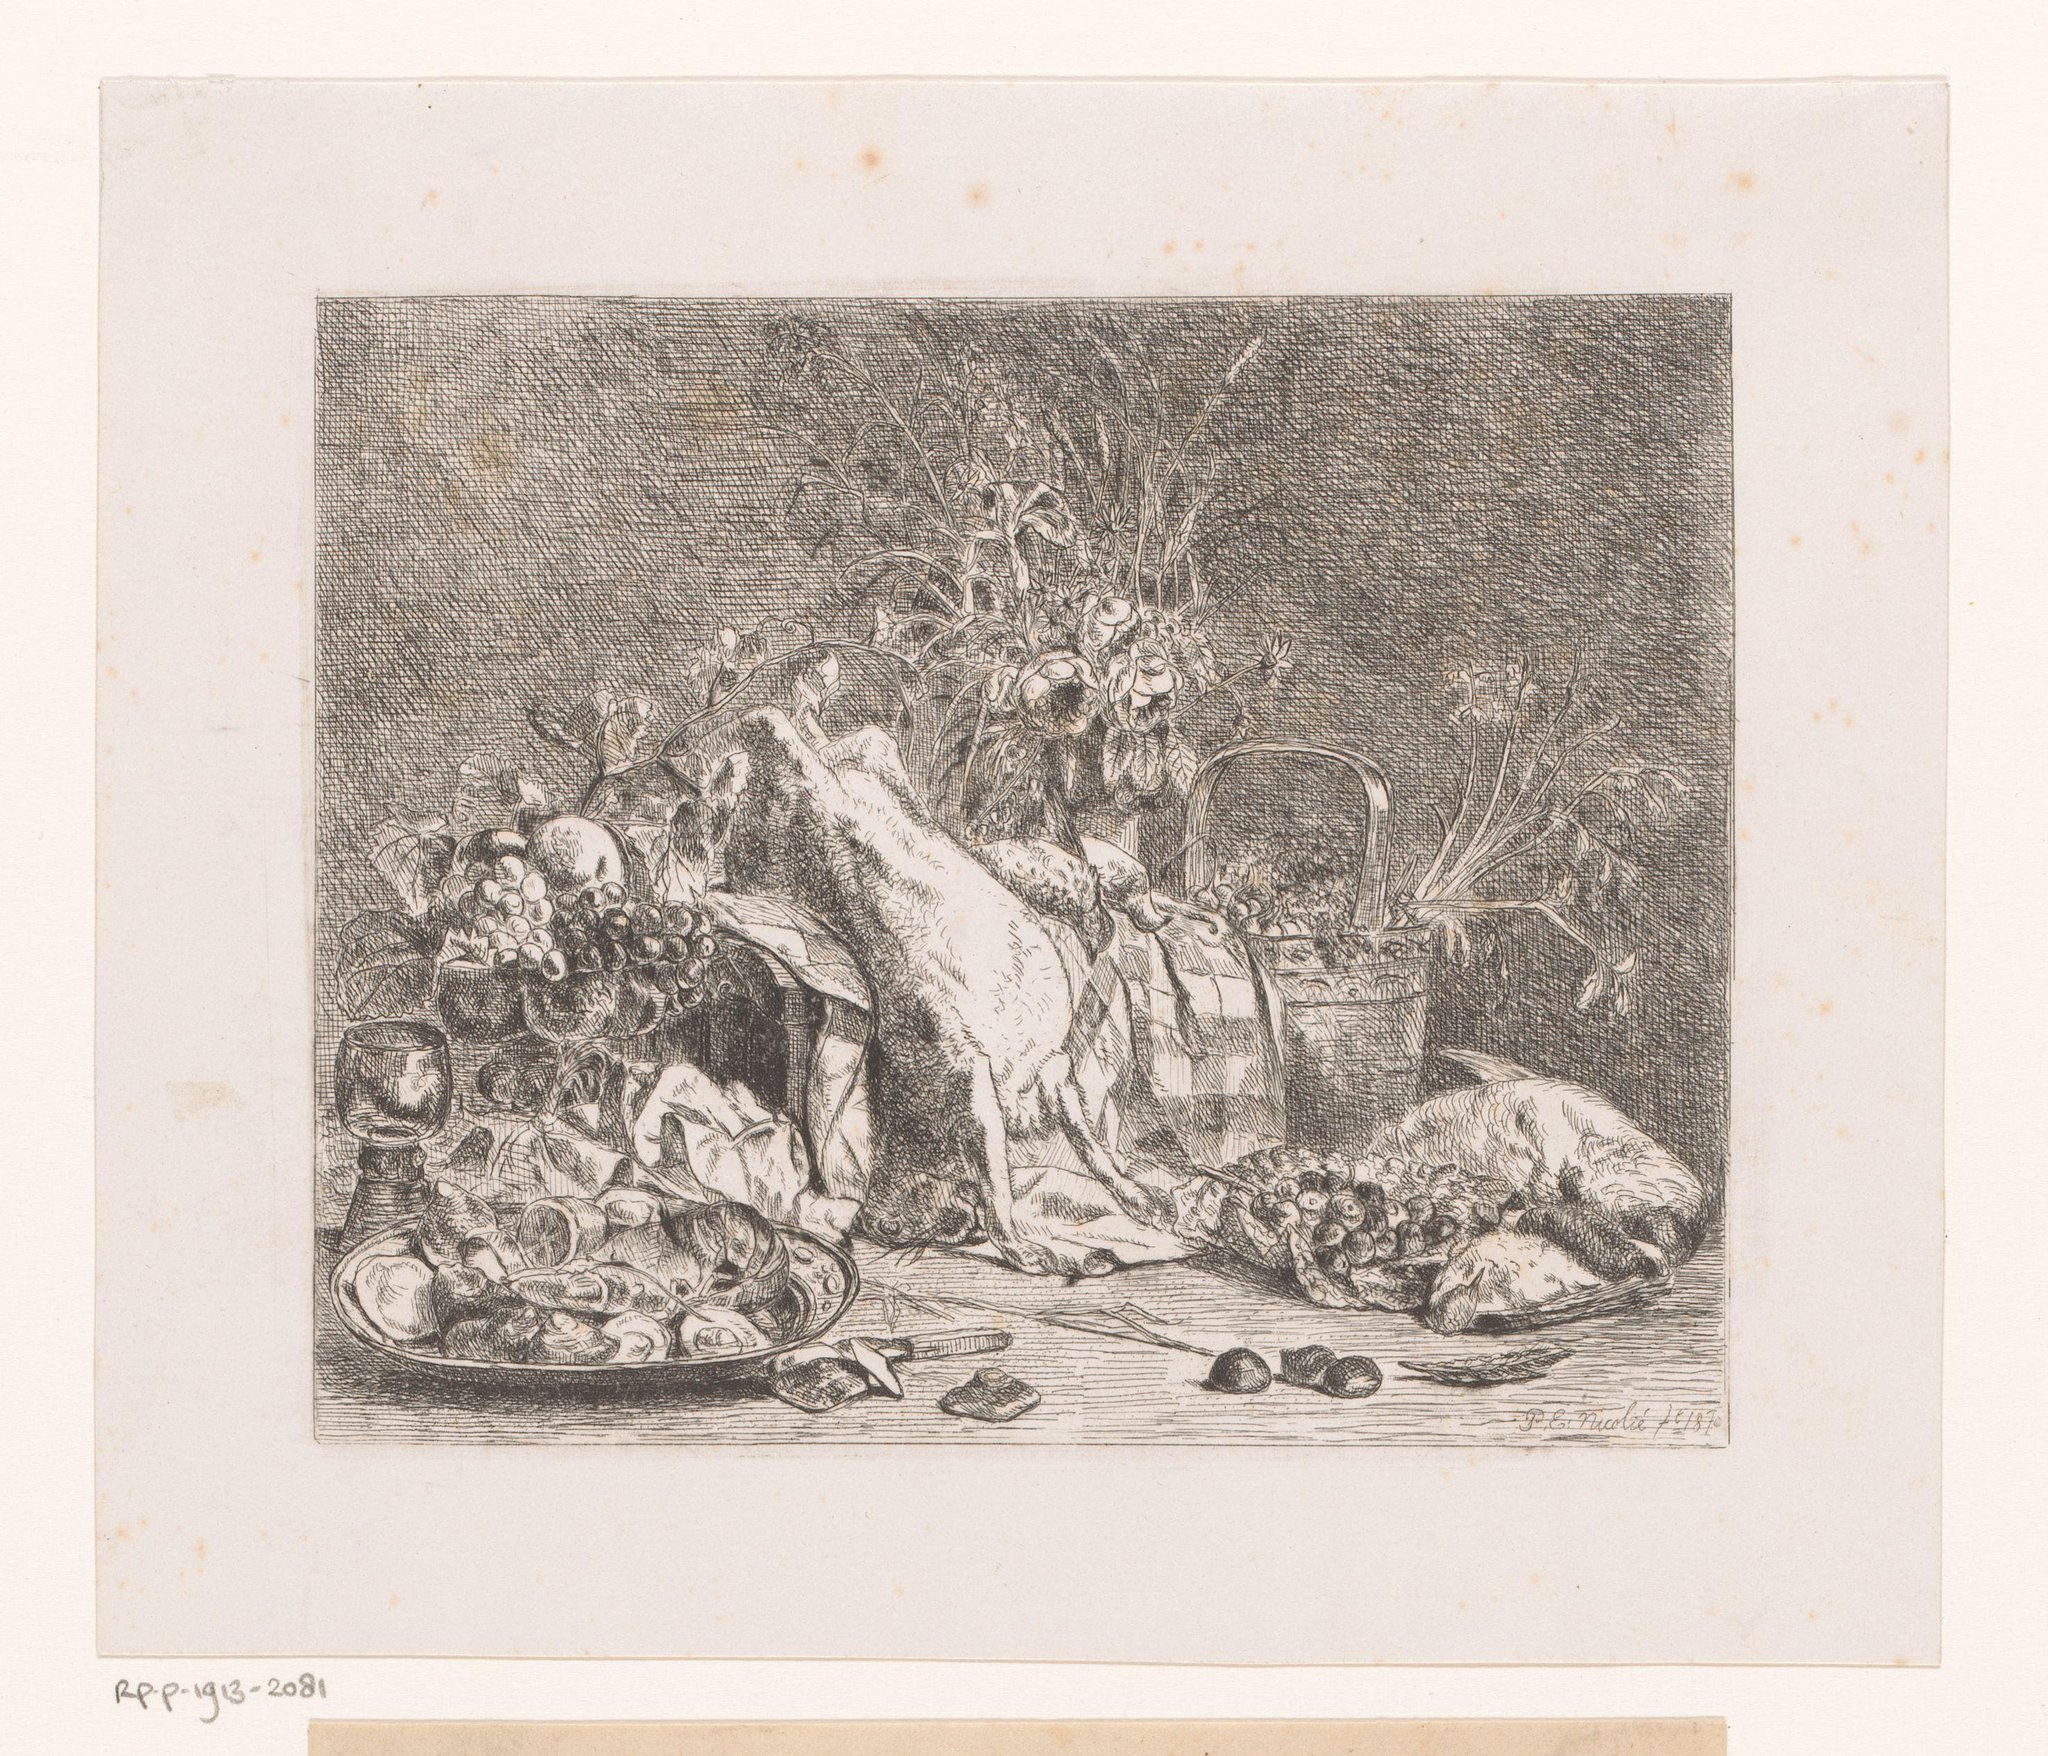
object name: print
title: Stilleven van bloemen, vruchten en wild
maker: paul emile nicolié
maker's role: print maker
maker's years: 1828-1894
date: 1870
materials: paper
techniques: etching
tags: rodents: hare, still life of plants, flowers and fruit, foodstuffs; still life of foodstuffs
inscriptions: collector's mark: Lugt 2228, collector's mark: Lugt 1485